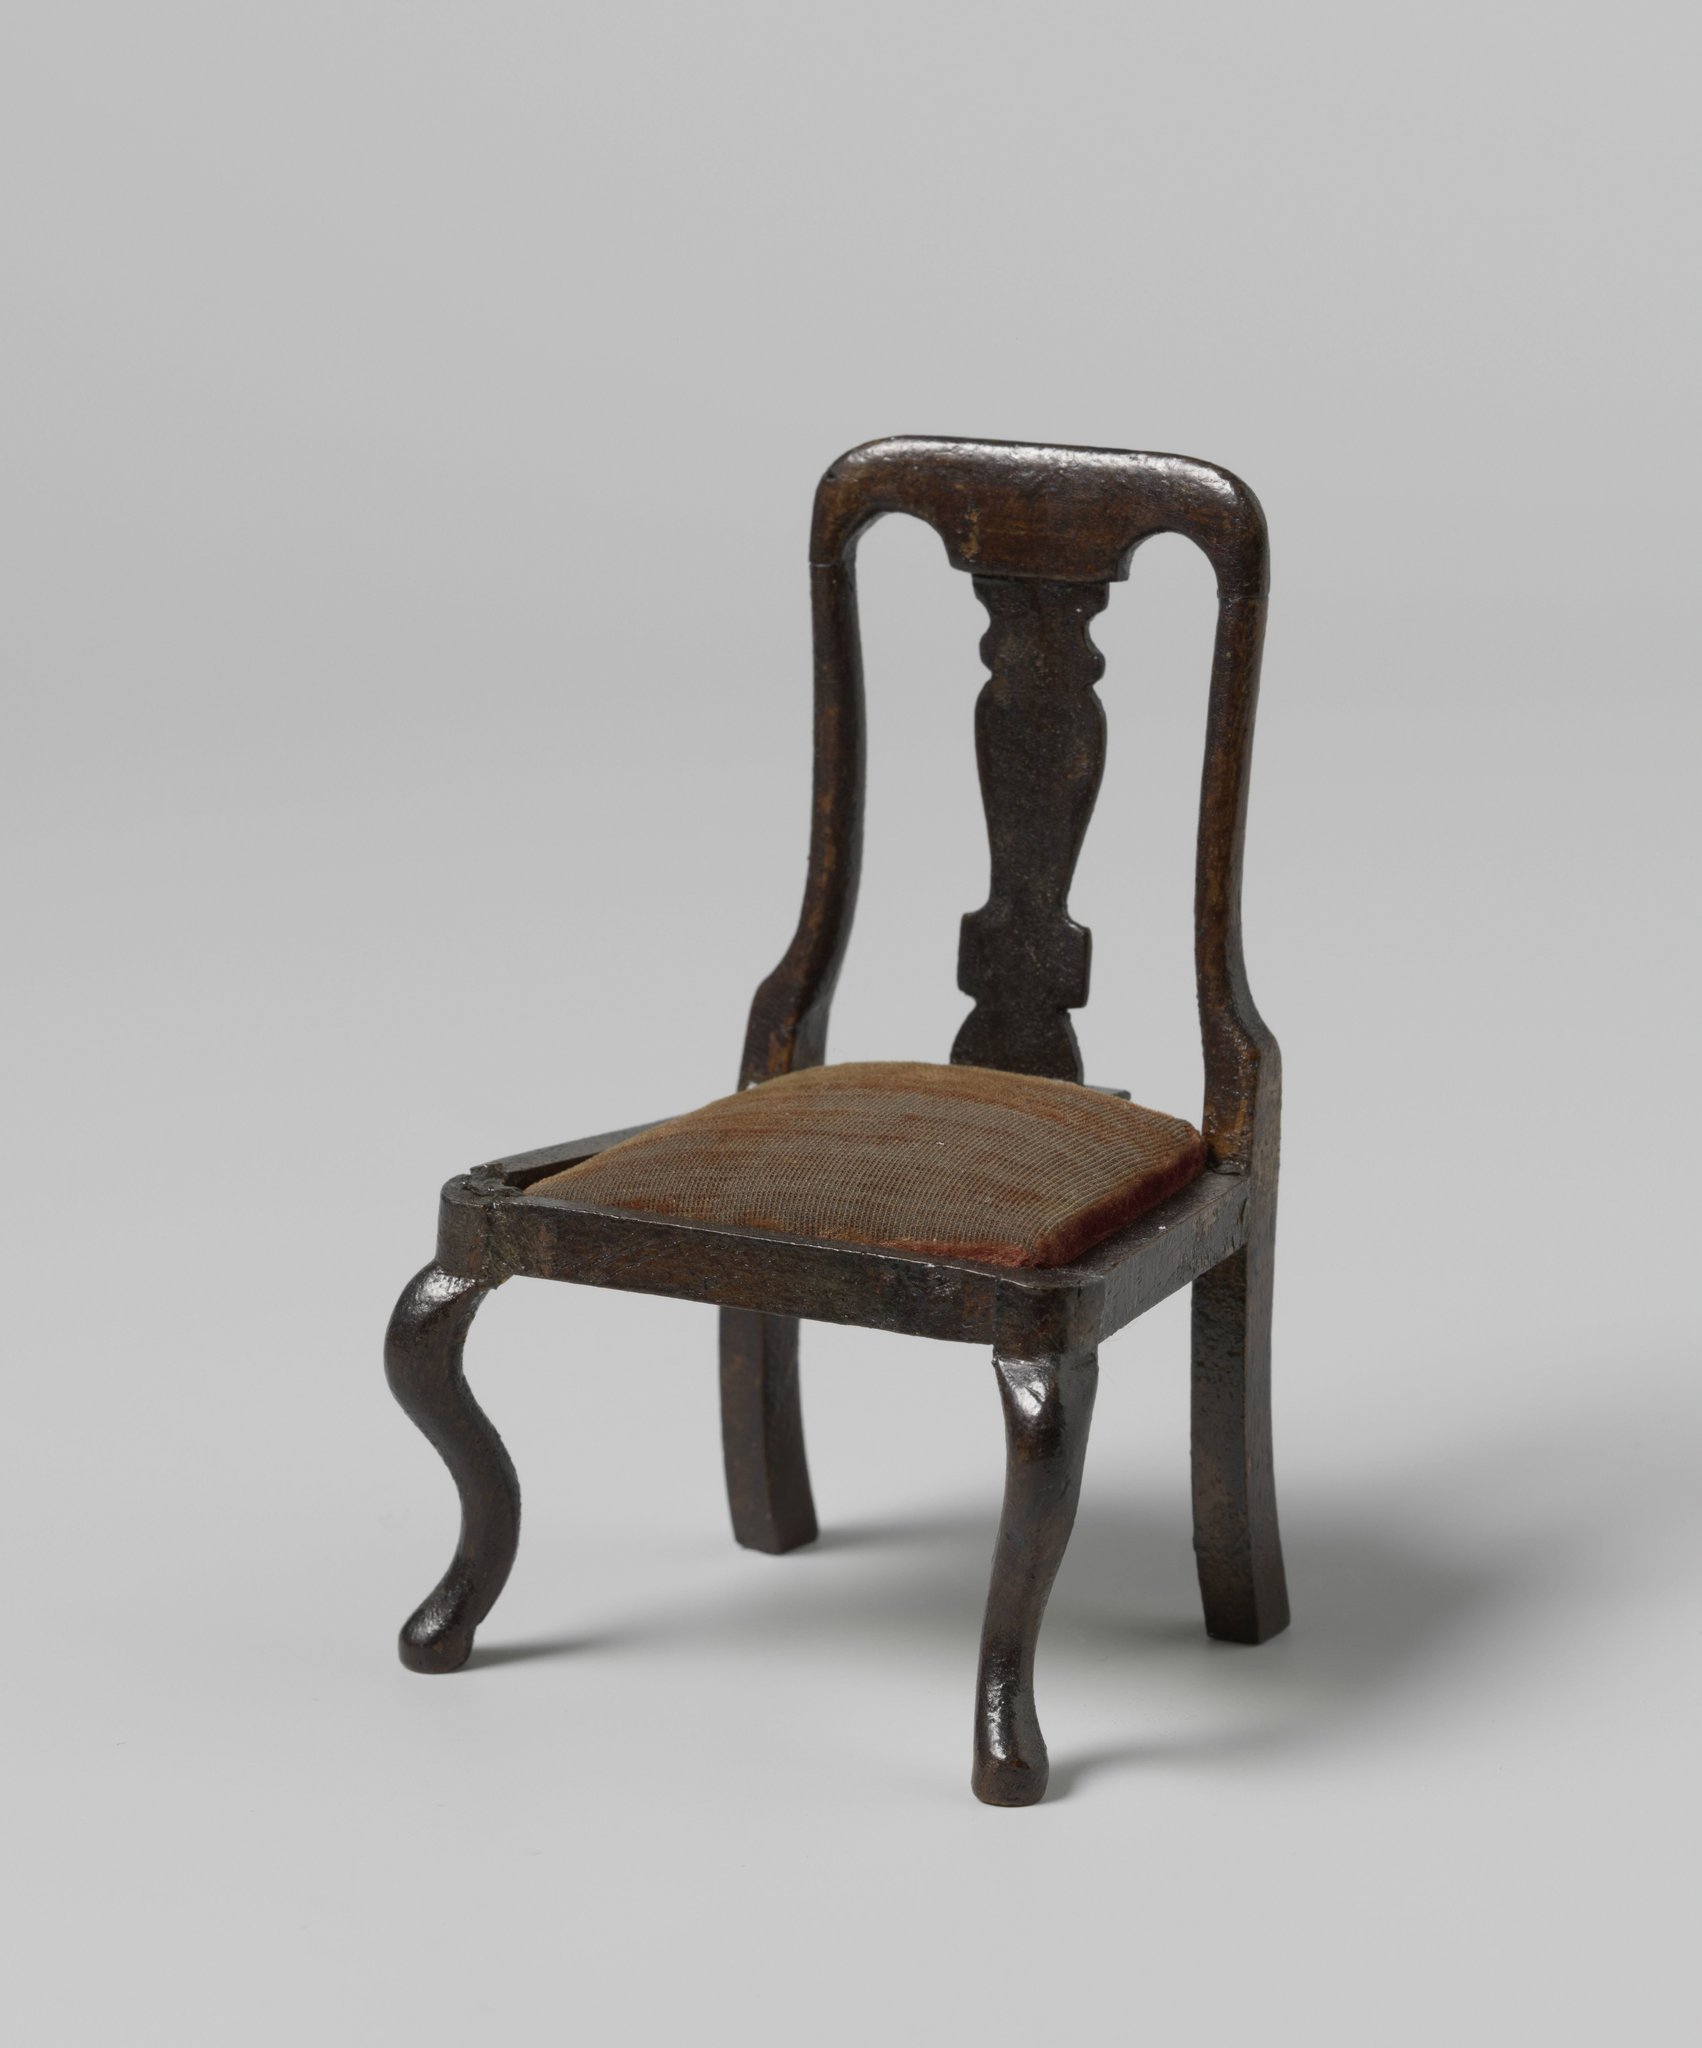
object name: chair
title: Stoel, de rug met vaasvormig middenblad, de zitting met bordeauxrode fluweel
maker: Anonymous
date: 1800-1899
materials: wood, velvet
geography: amsterdam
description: Stoel van mahoniehout. De rug is open met een vaasvormig middenblad. De stoel heeft een trapezium-vormig open zitraam met losse zitting met bordeauxrode fluweel.